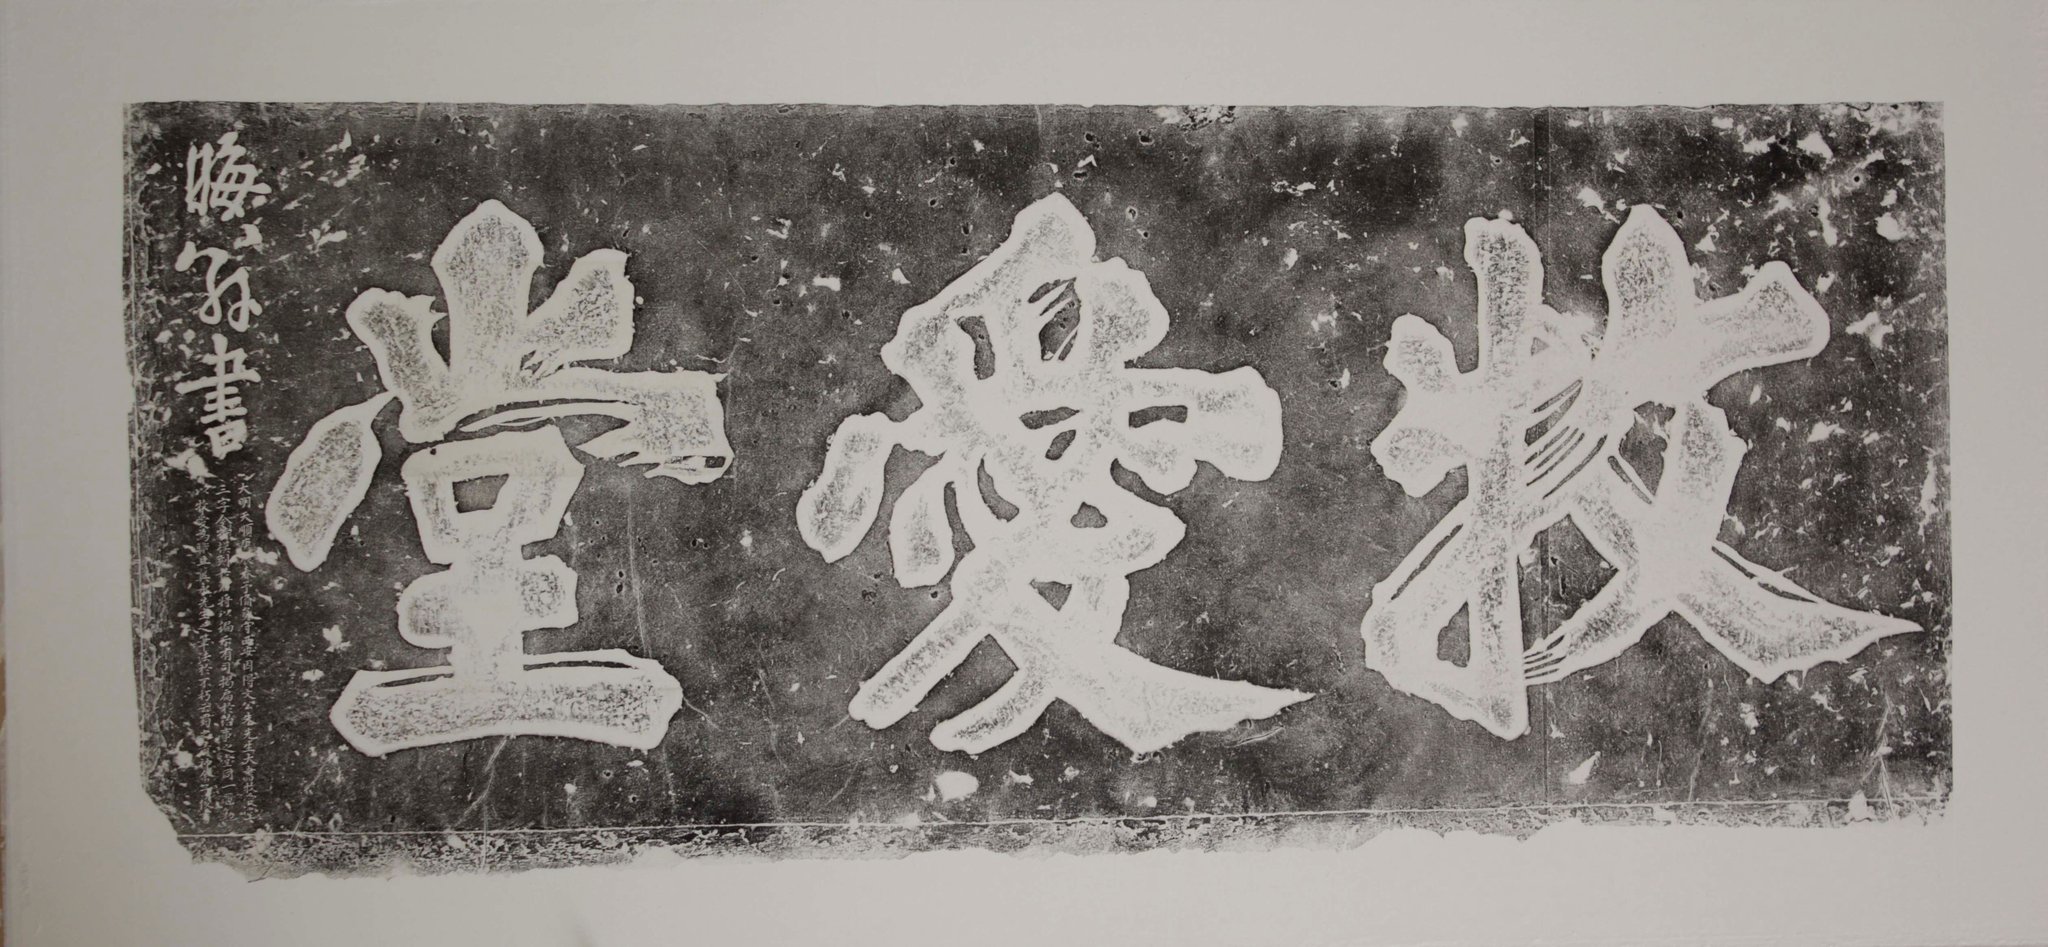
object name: rubbing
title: Placard for Muai Hall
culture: chinese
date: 1901-2000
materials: ink, paper